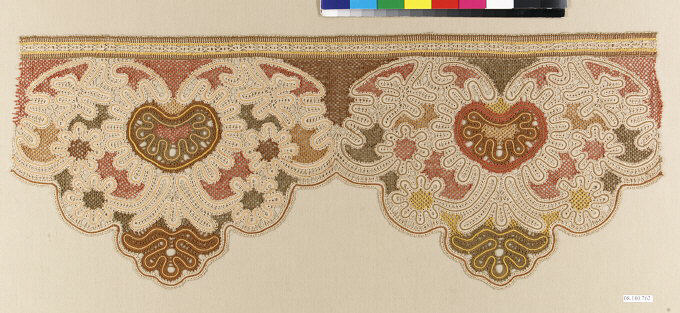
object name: fragment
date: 1801-1900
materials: linen, silk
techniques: lace